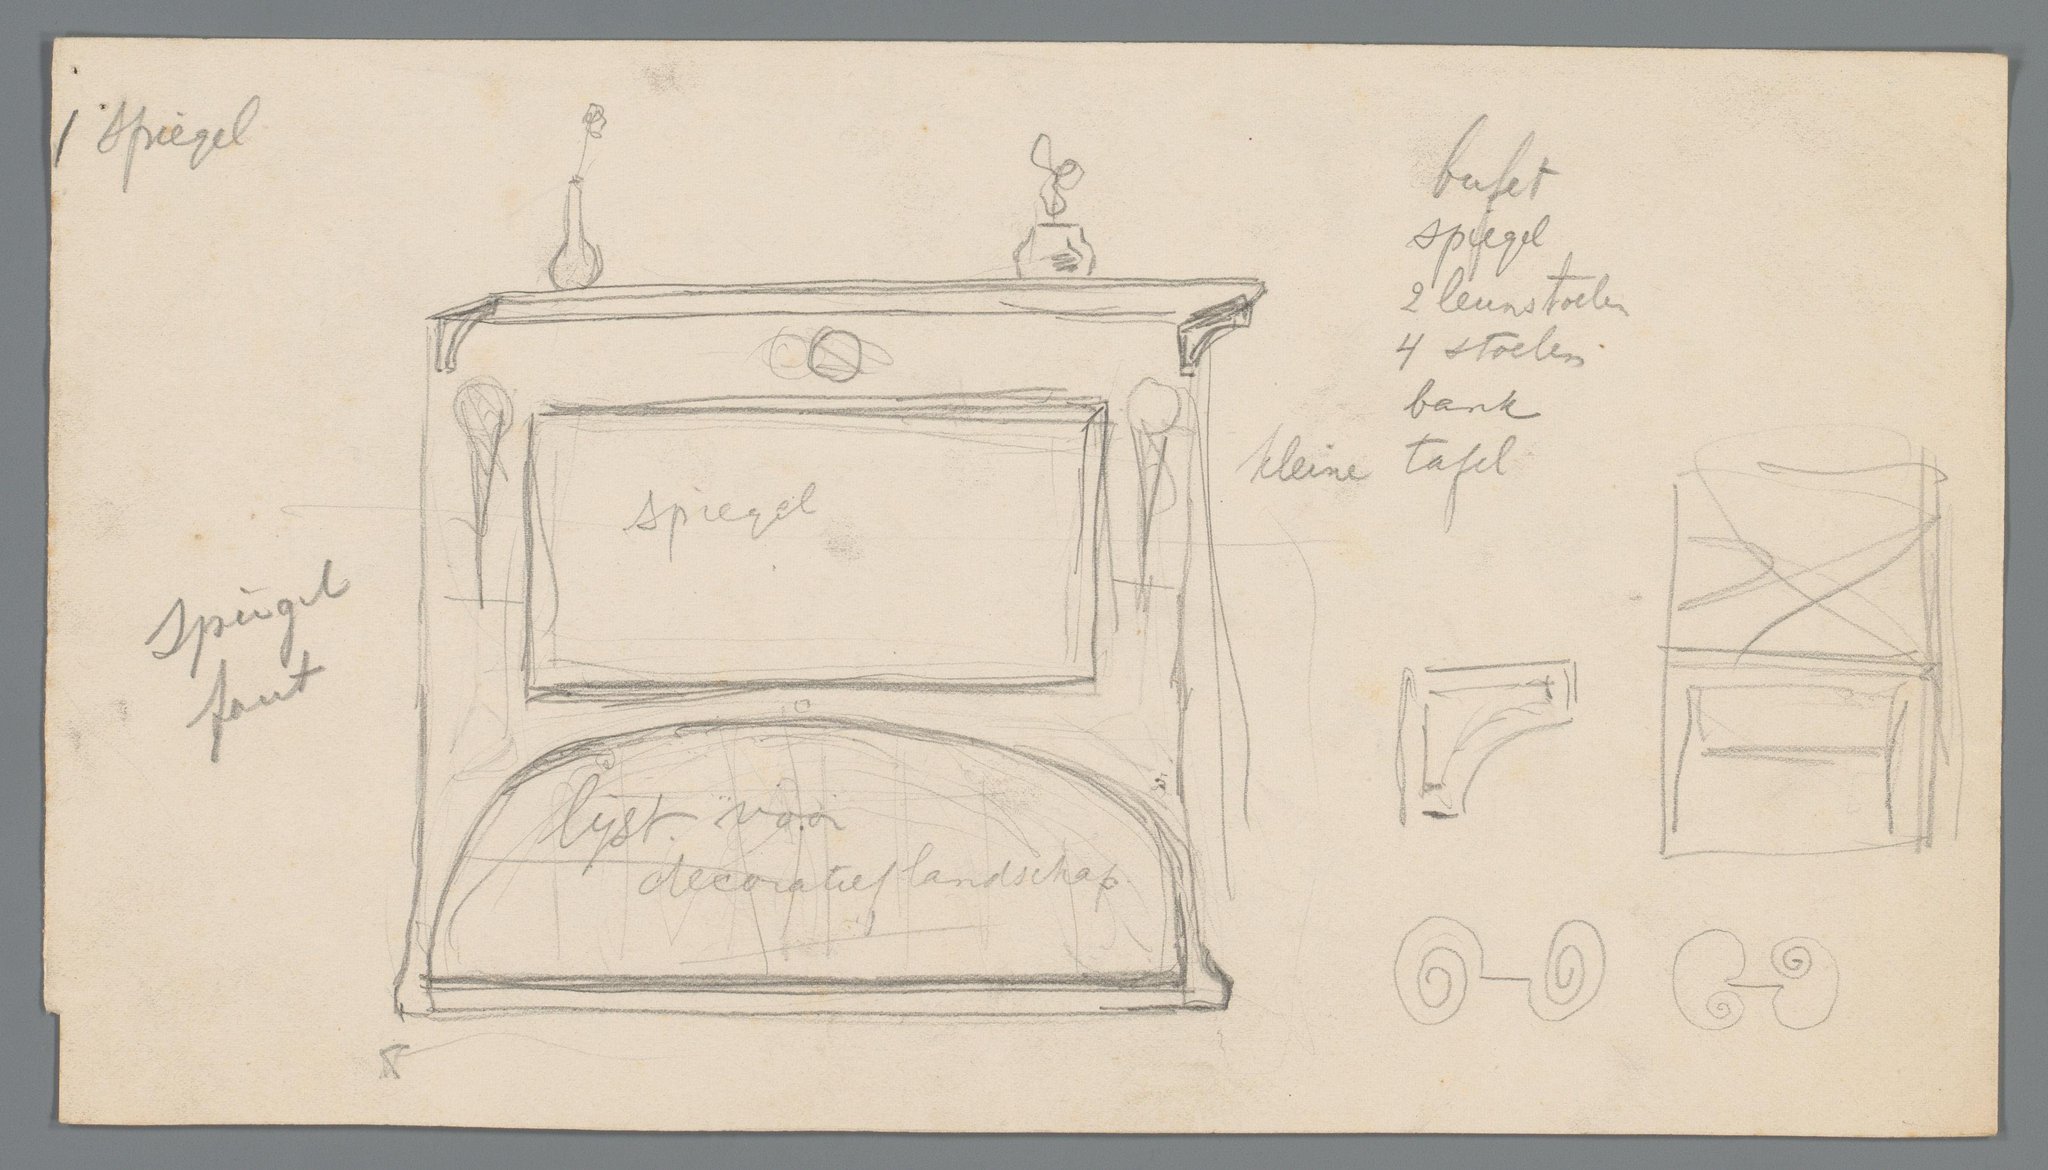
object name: design drawing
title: Ontwerp voor een meubel met spiegel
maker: gust van de wall perné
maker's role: draughtsman, painter, print maker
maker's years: 1877-1911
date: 1887-1911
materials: paper, pencil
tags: decorative furniture, mirror